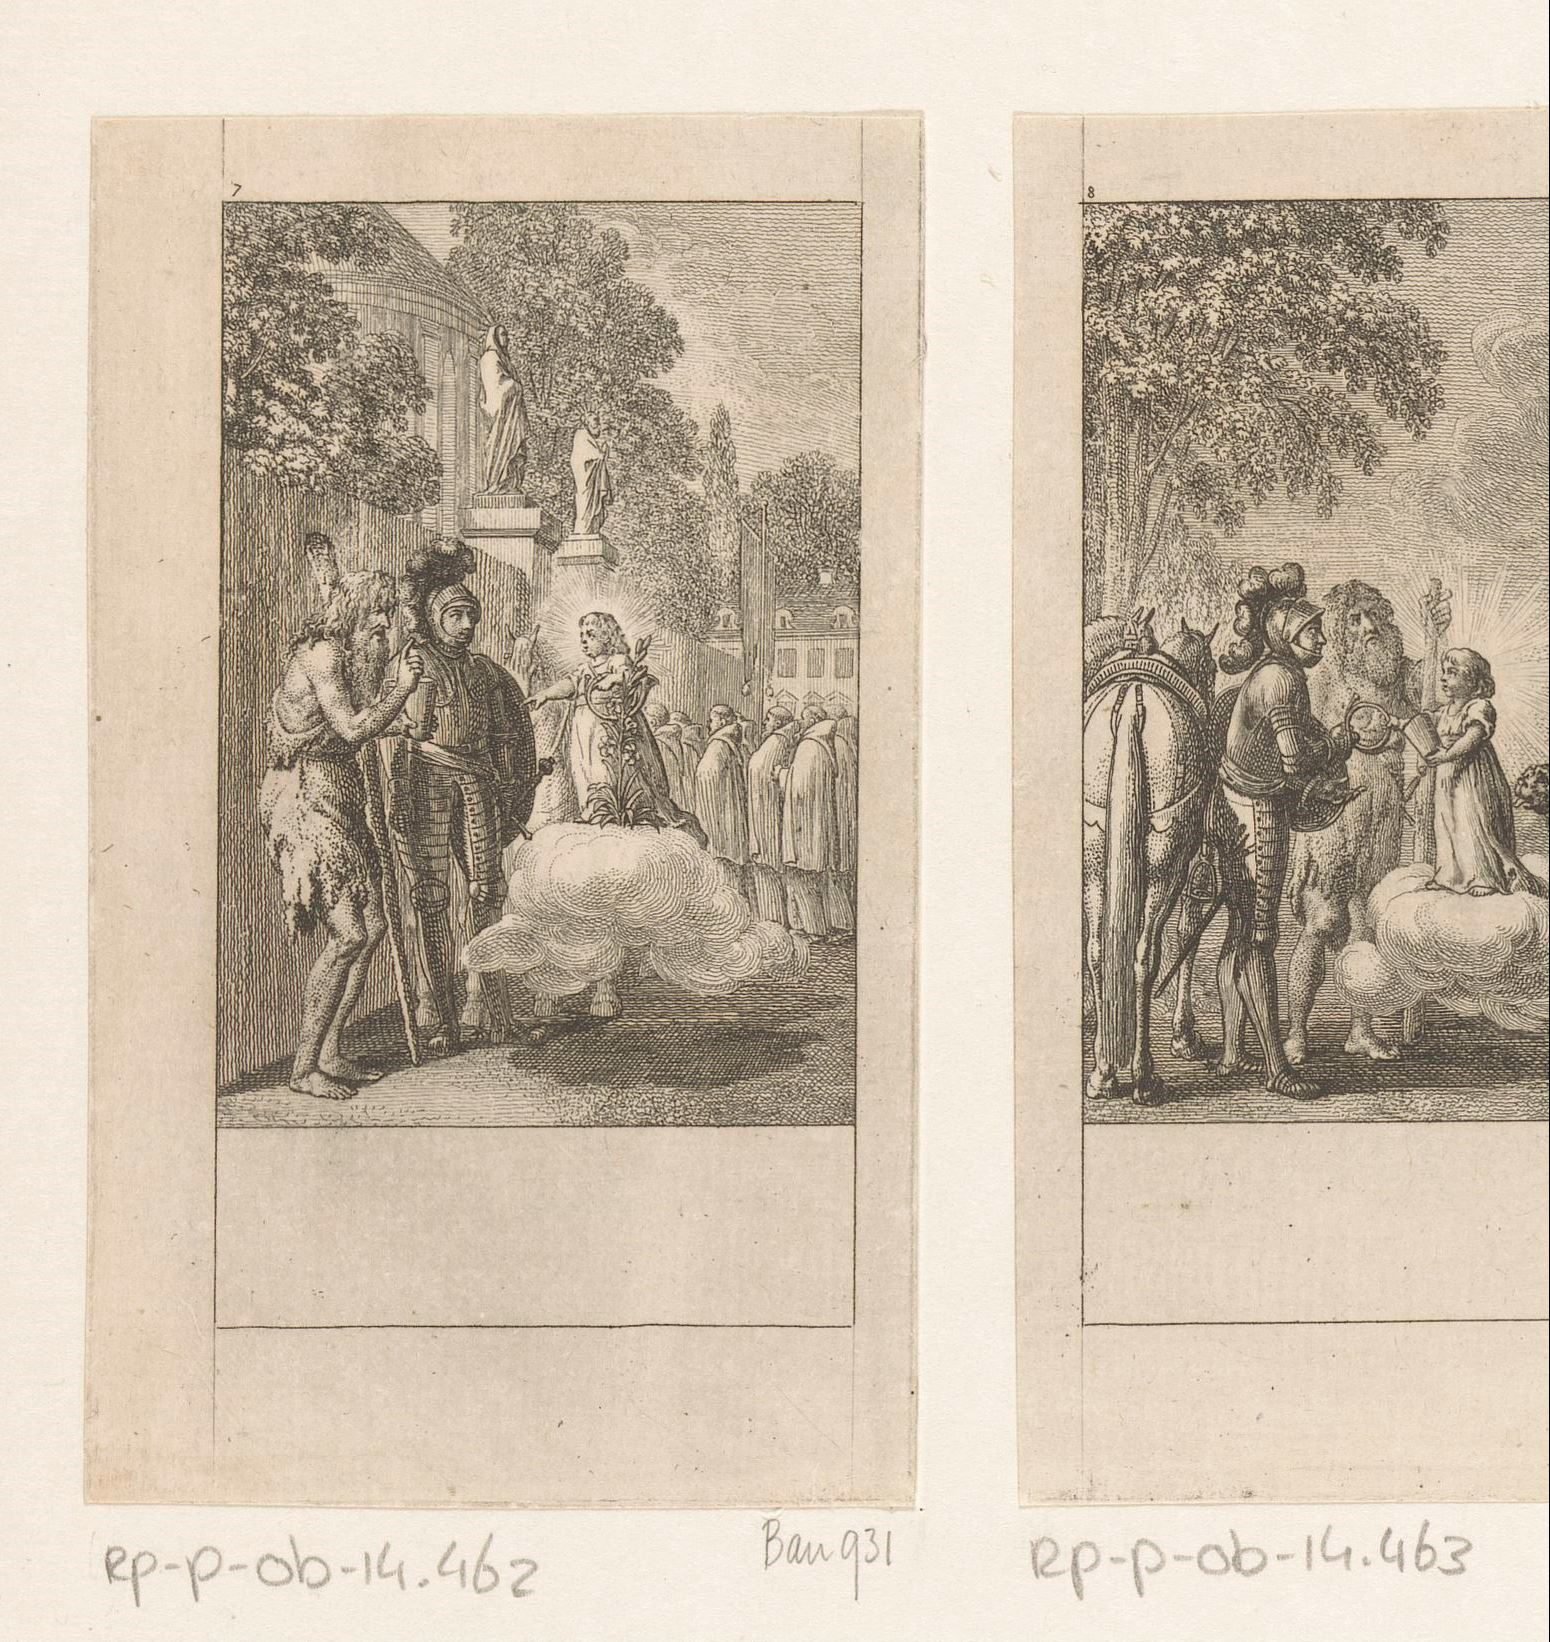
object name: print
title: Huon de Bordeaux en Gérasme in gesprek met de feeënkoning Oberon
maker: daniel nikolaus chodowiecki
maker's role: draughtsman, print maker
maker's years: 1726-1801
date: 1782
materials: paper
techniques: etching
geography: berlin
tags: wild man, wodewose, woodehouse, going to church, armour, sitting or standing on clouds, child (at home)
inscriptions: collector's mark: Lugt 2228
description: Vervaardigd voor Tressans 'Huon de Bordeaux'. Latere staat gebruikt voor: Almanac de Gotha contenant diverses connaissances curieuses et utiles pour l'année MDCCLXXXIII. Gotha: C. W. Ettinger, 1782.